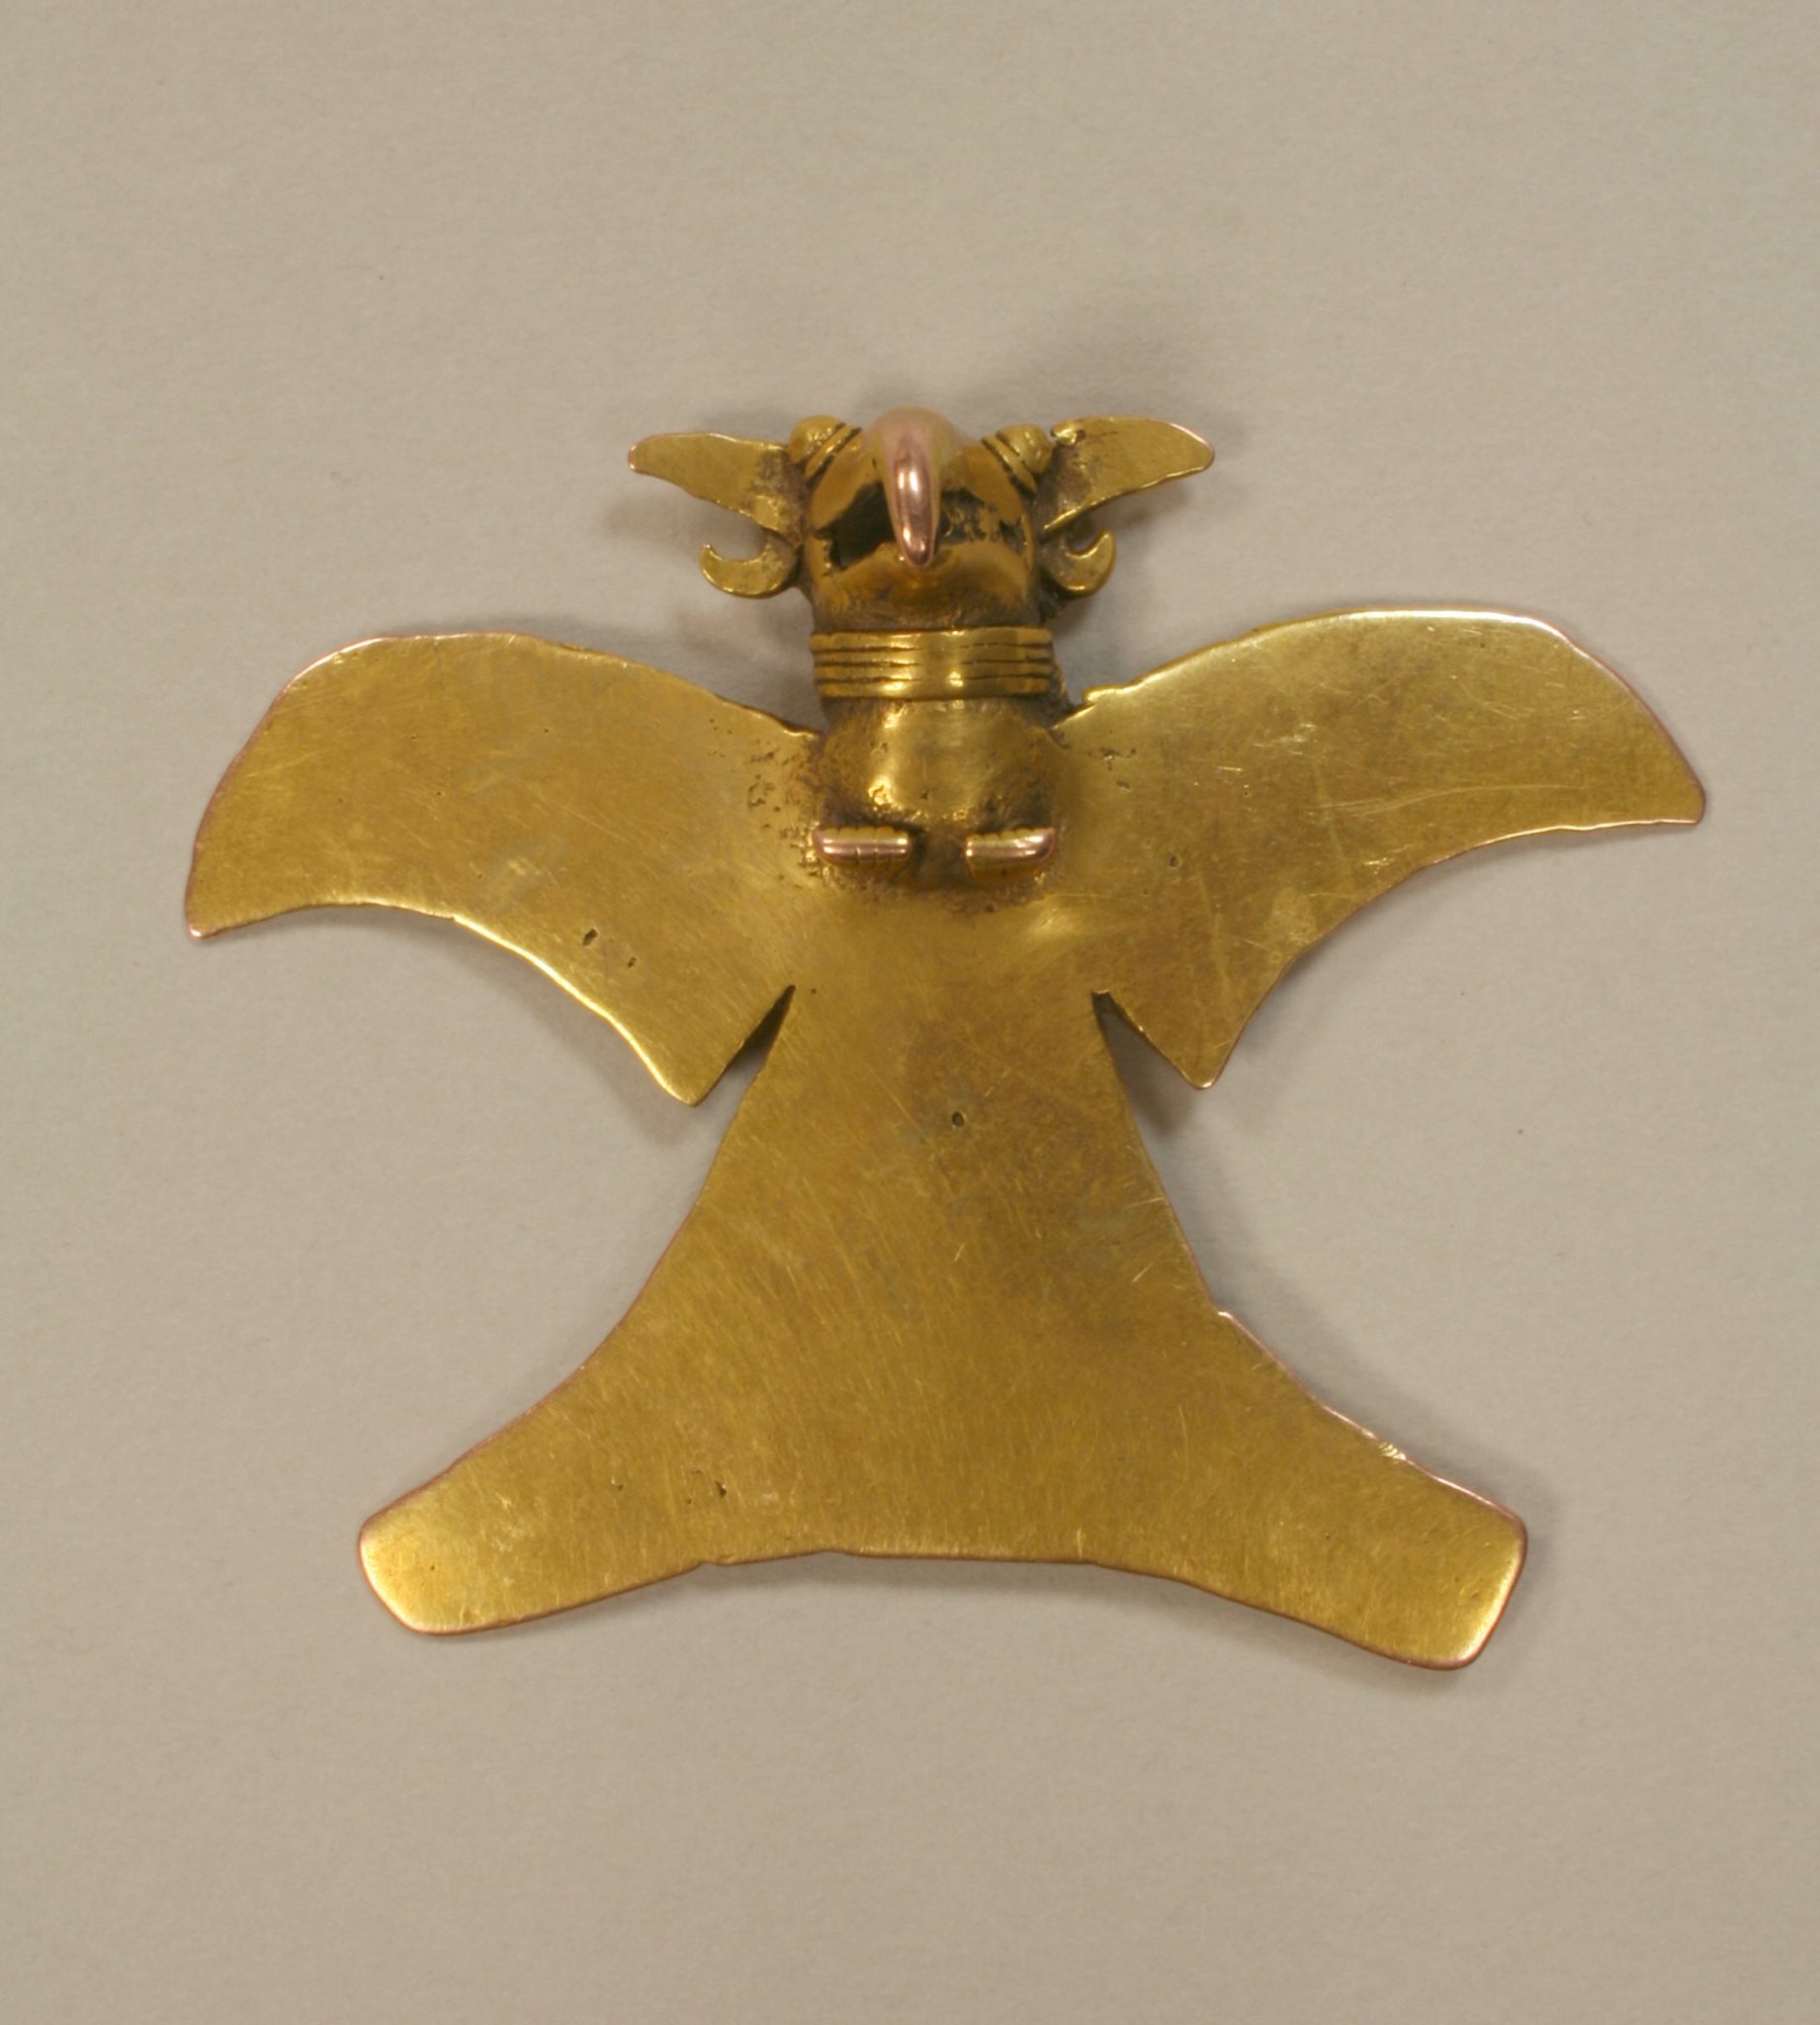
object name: pendant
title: Eagle Pendant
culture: veraguas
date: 1001-1500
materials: gold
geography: panama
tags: eagles